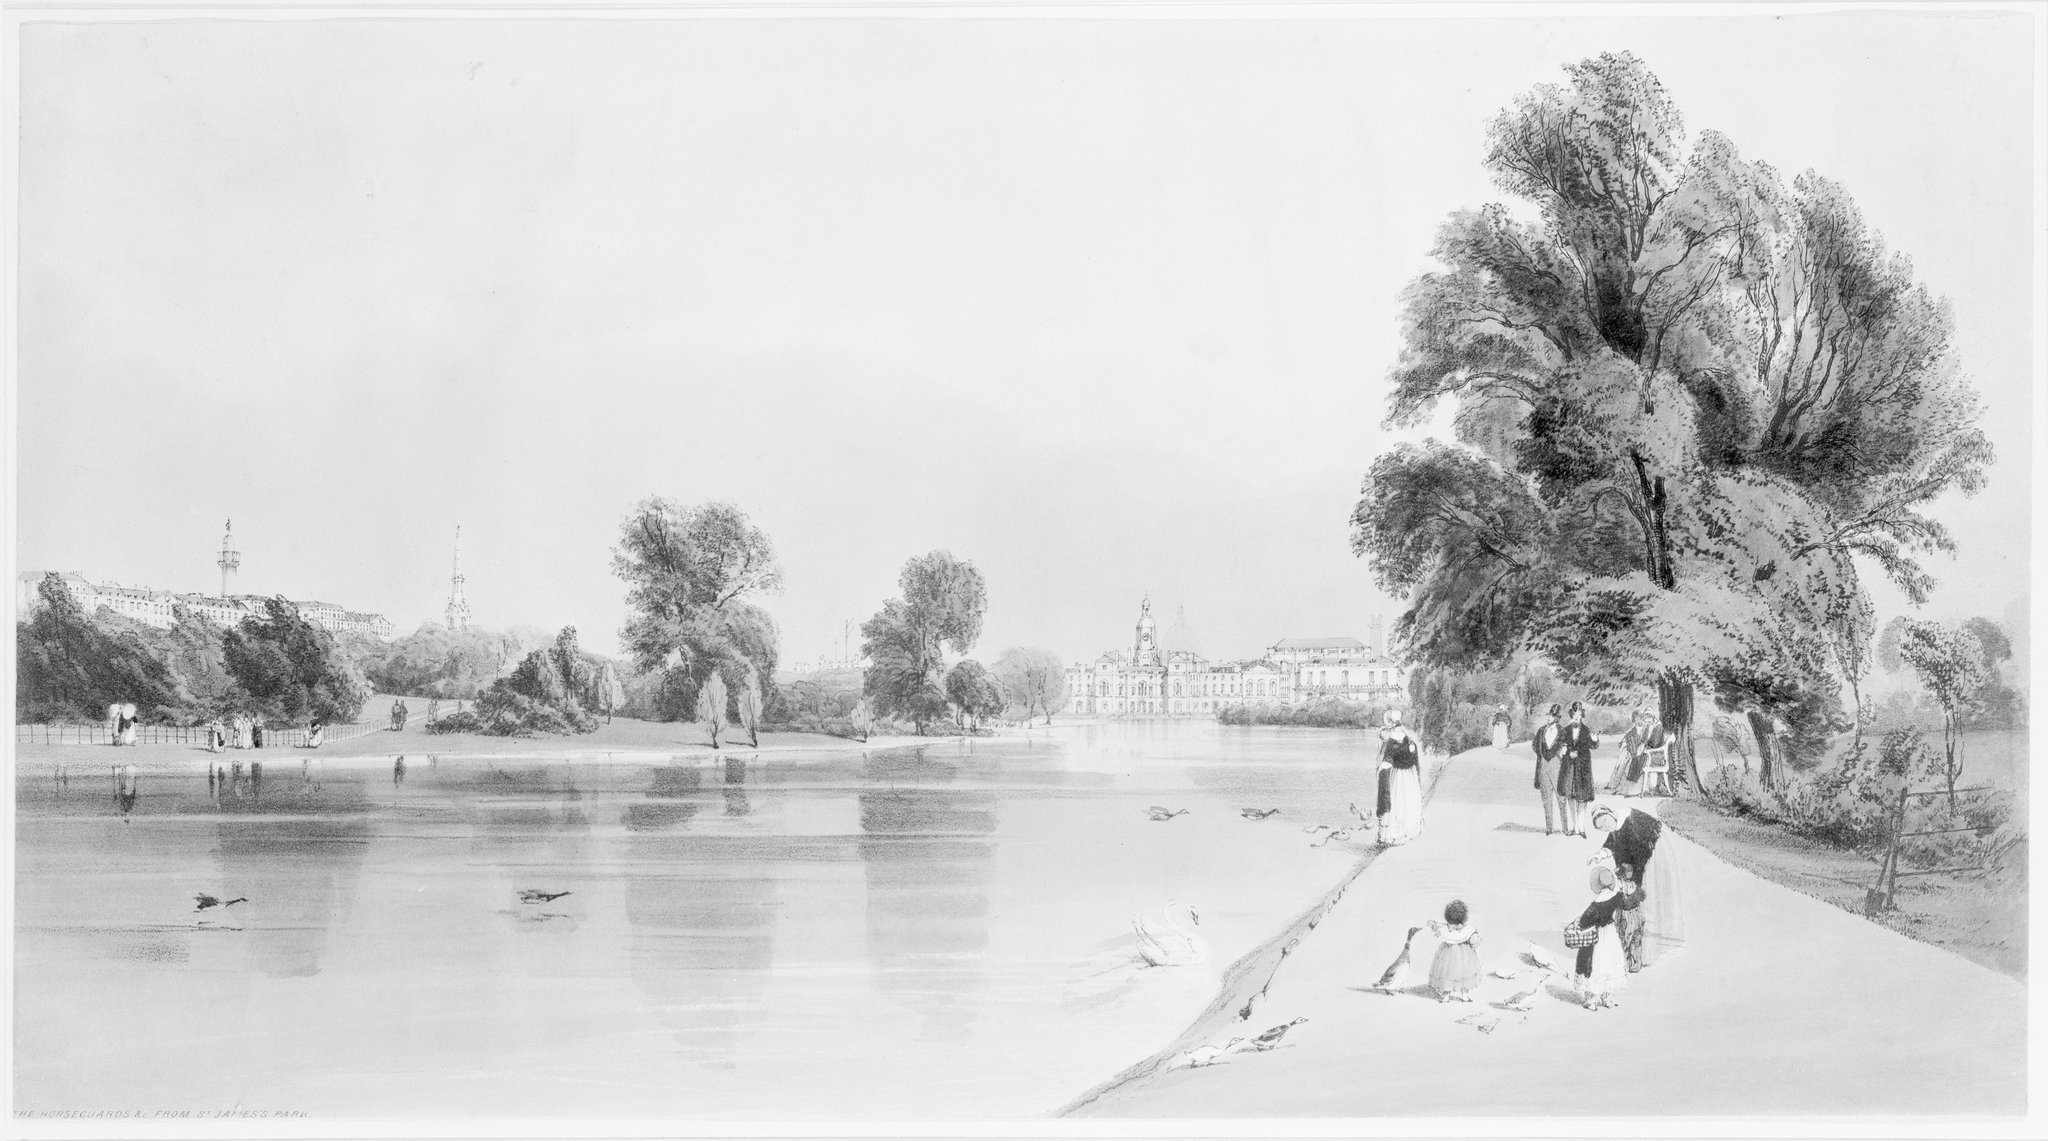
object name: print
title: The Horse Guards &c. from St. James's Park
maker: thomas shotter boys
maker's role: artist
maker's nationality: british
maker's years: 1803-1874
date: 1842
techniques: hand coloring, lithograph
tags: parks,ponds